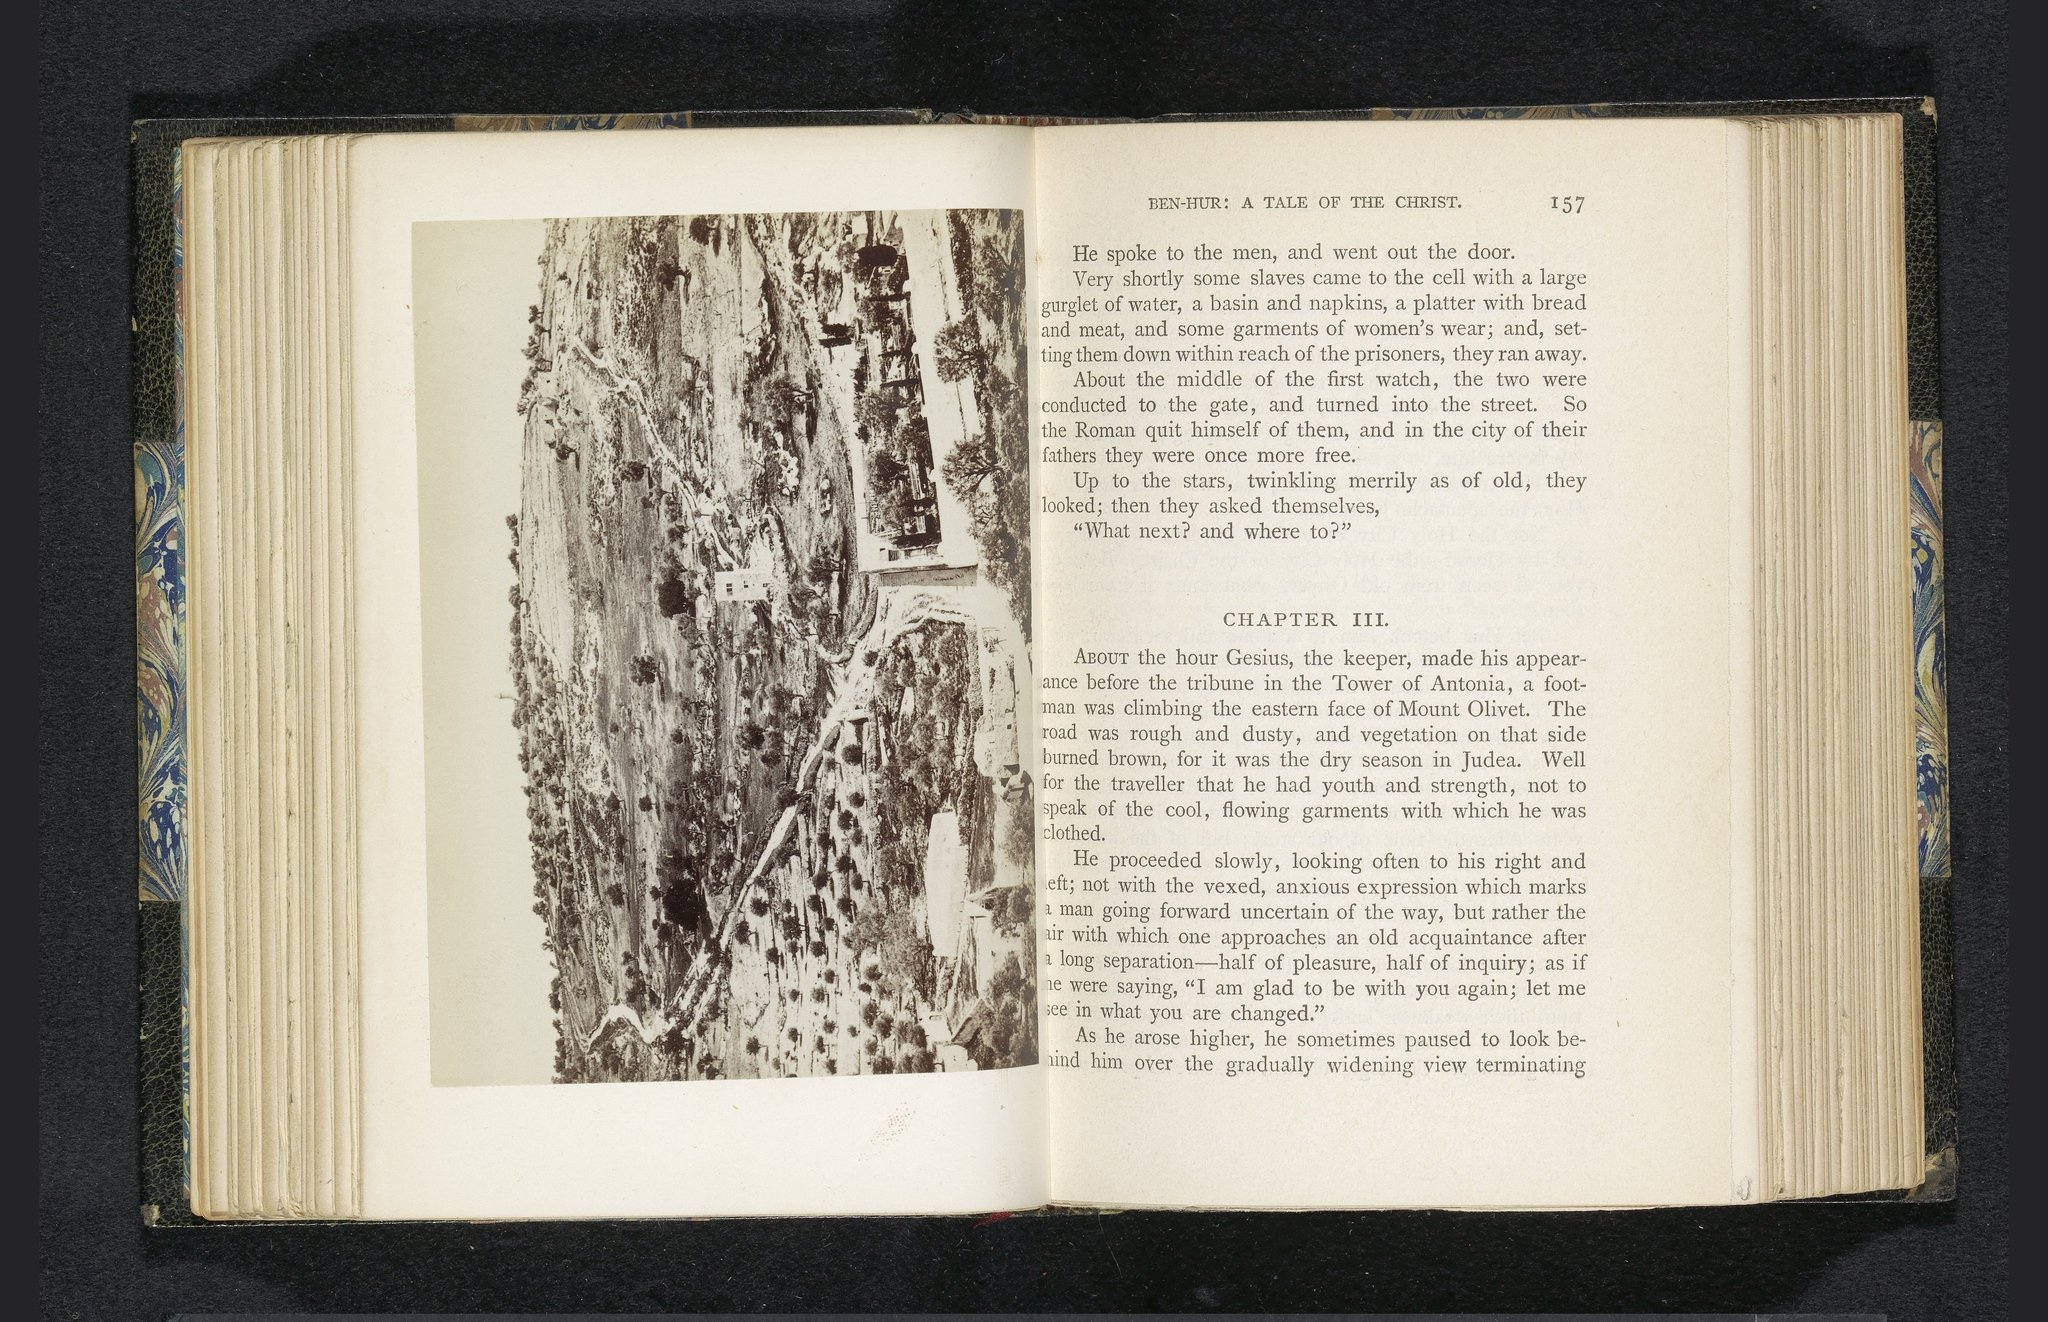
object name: page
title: Gezicht op de Olijfberg te Jeruzalem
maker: Anonymous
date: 1883-1888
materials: photographic support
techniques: albumen print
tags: mountains